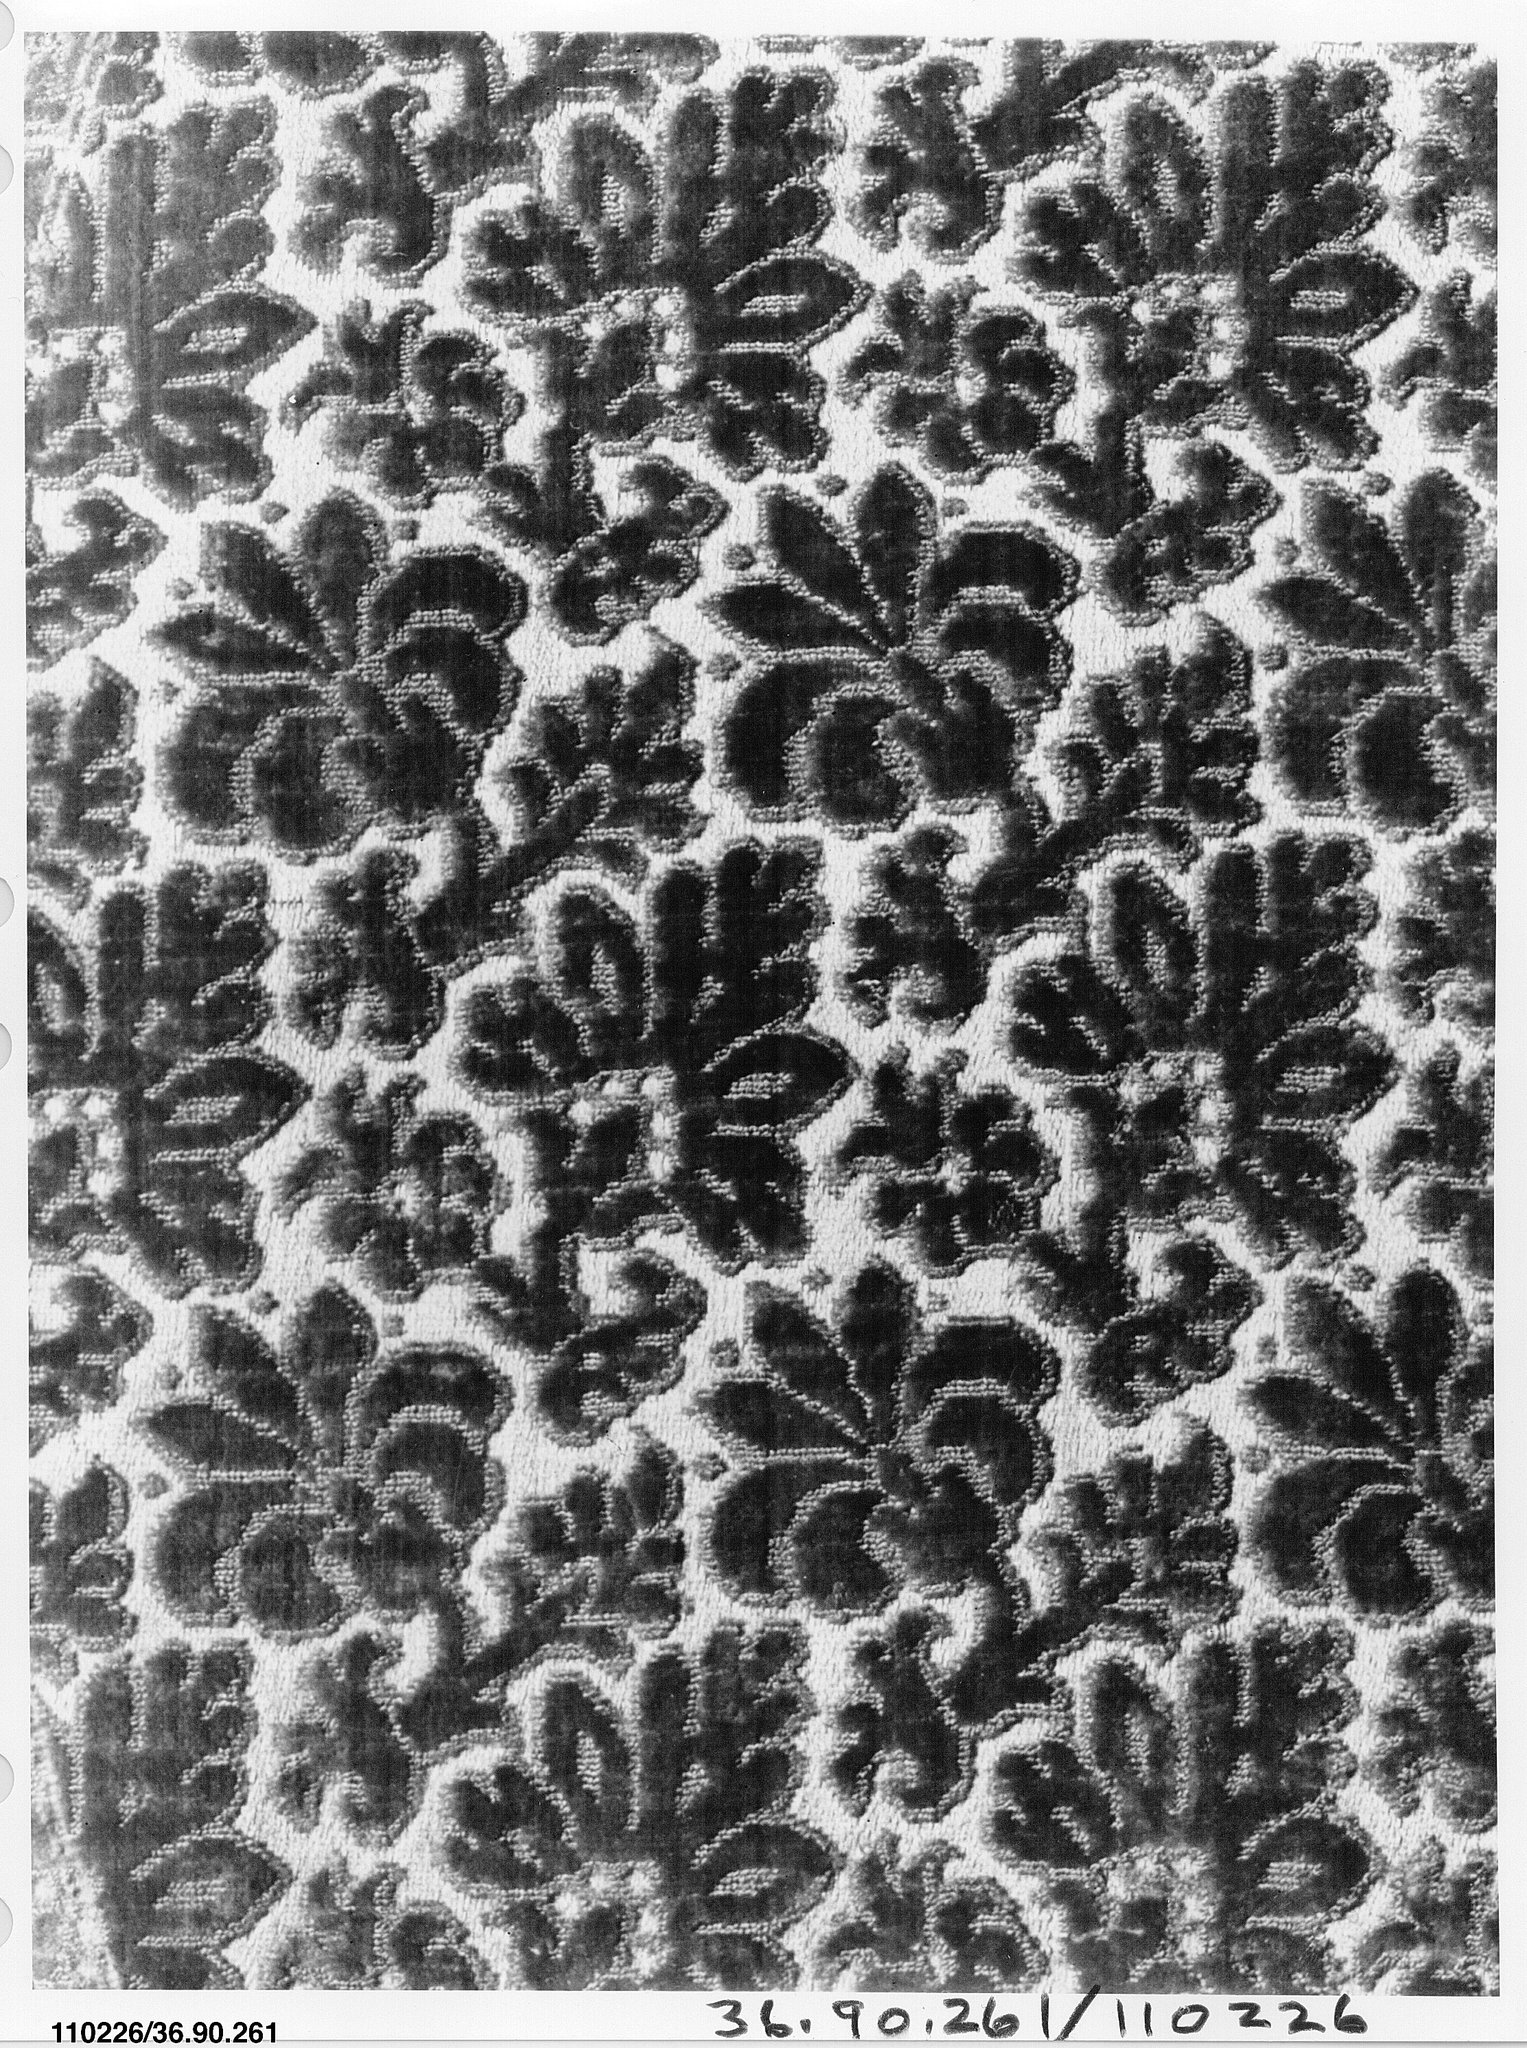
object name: piece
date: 1501-1700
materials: silk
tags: flowers